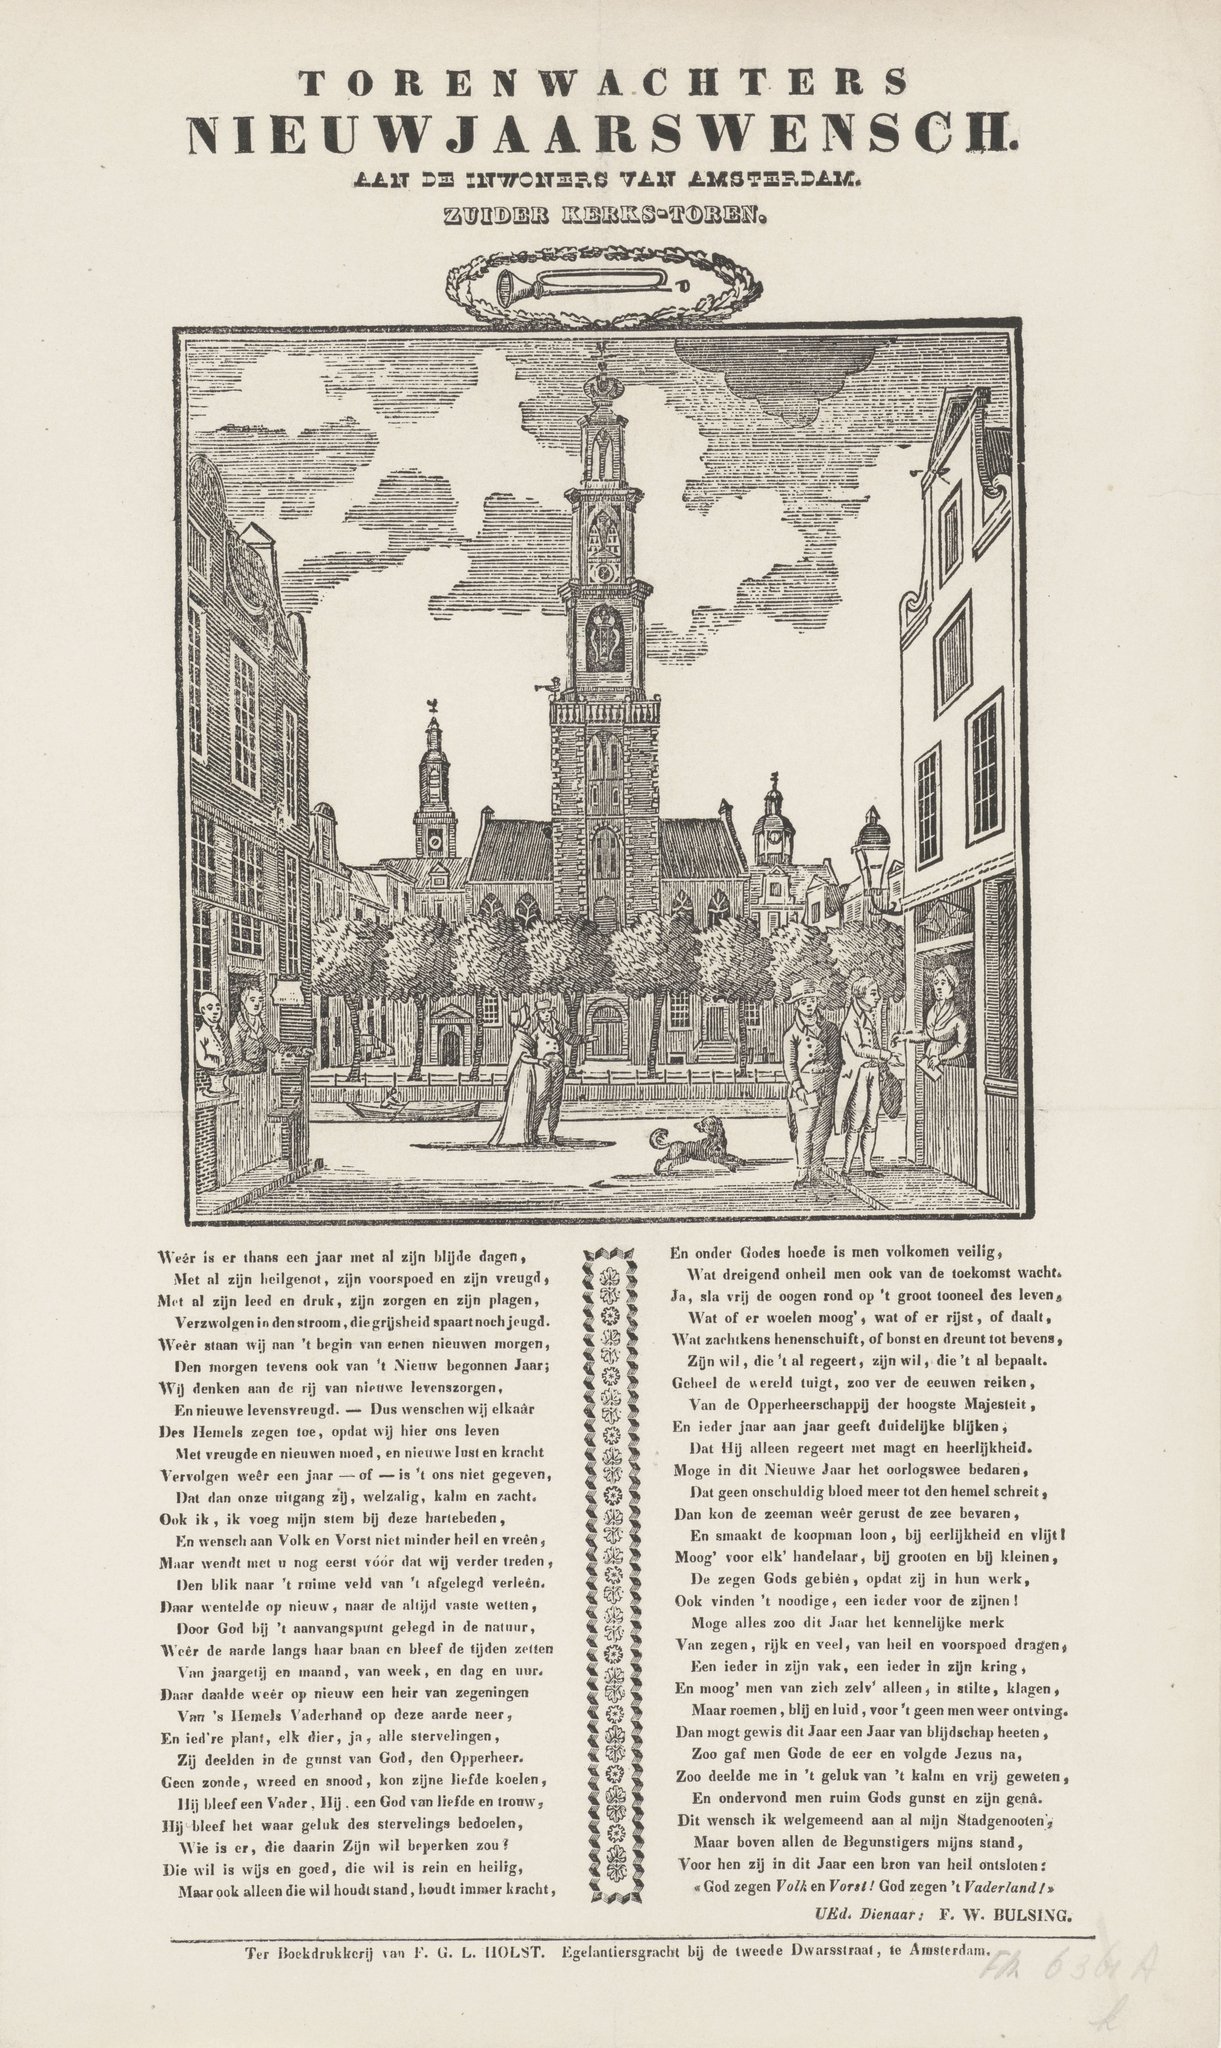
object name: new year card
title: Torenwachters Nieuwjaarswensch (...) Zuider-Kerkstoren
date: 1840-1870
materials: paper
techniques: letterpress printing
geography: amsterdam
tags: tower sentry, street, amsterdam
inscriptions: collector's mark: Lugt 2228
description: Nieuwjaarswens van de torenwachter van de Amsterdamse Zuiderkerk, ca. 1840-1870. Gezicht op de Westerkerk te Amsterdam, twee mannen halen aan de huizen geld op. Onderaan een gedicht in twee kolommen. Van de torenwachter: F.W. Bulsing.